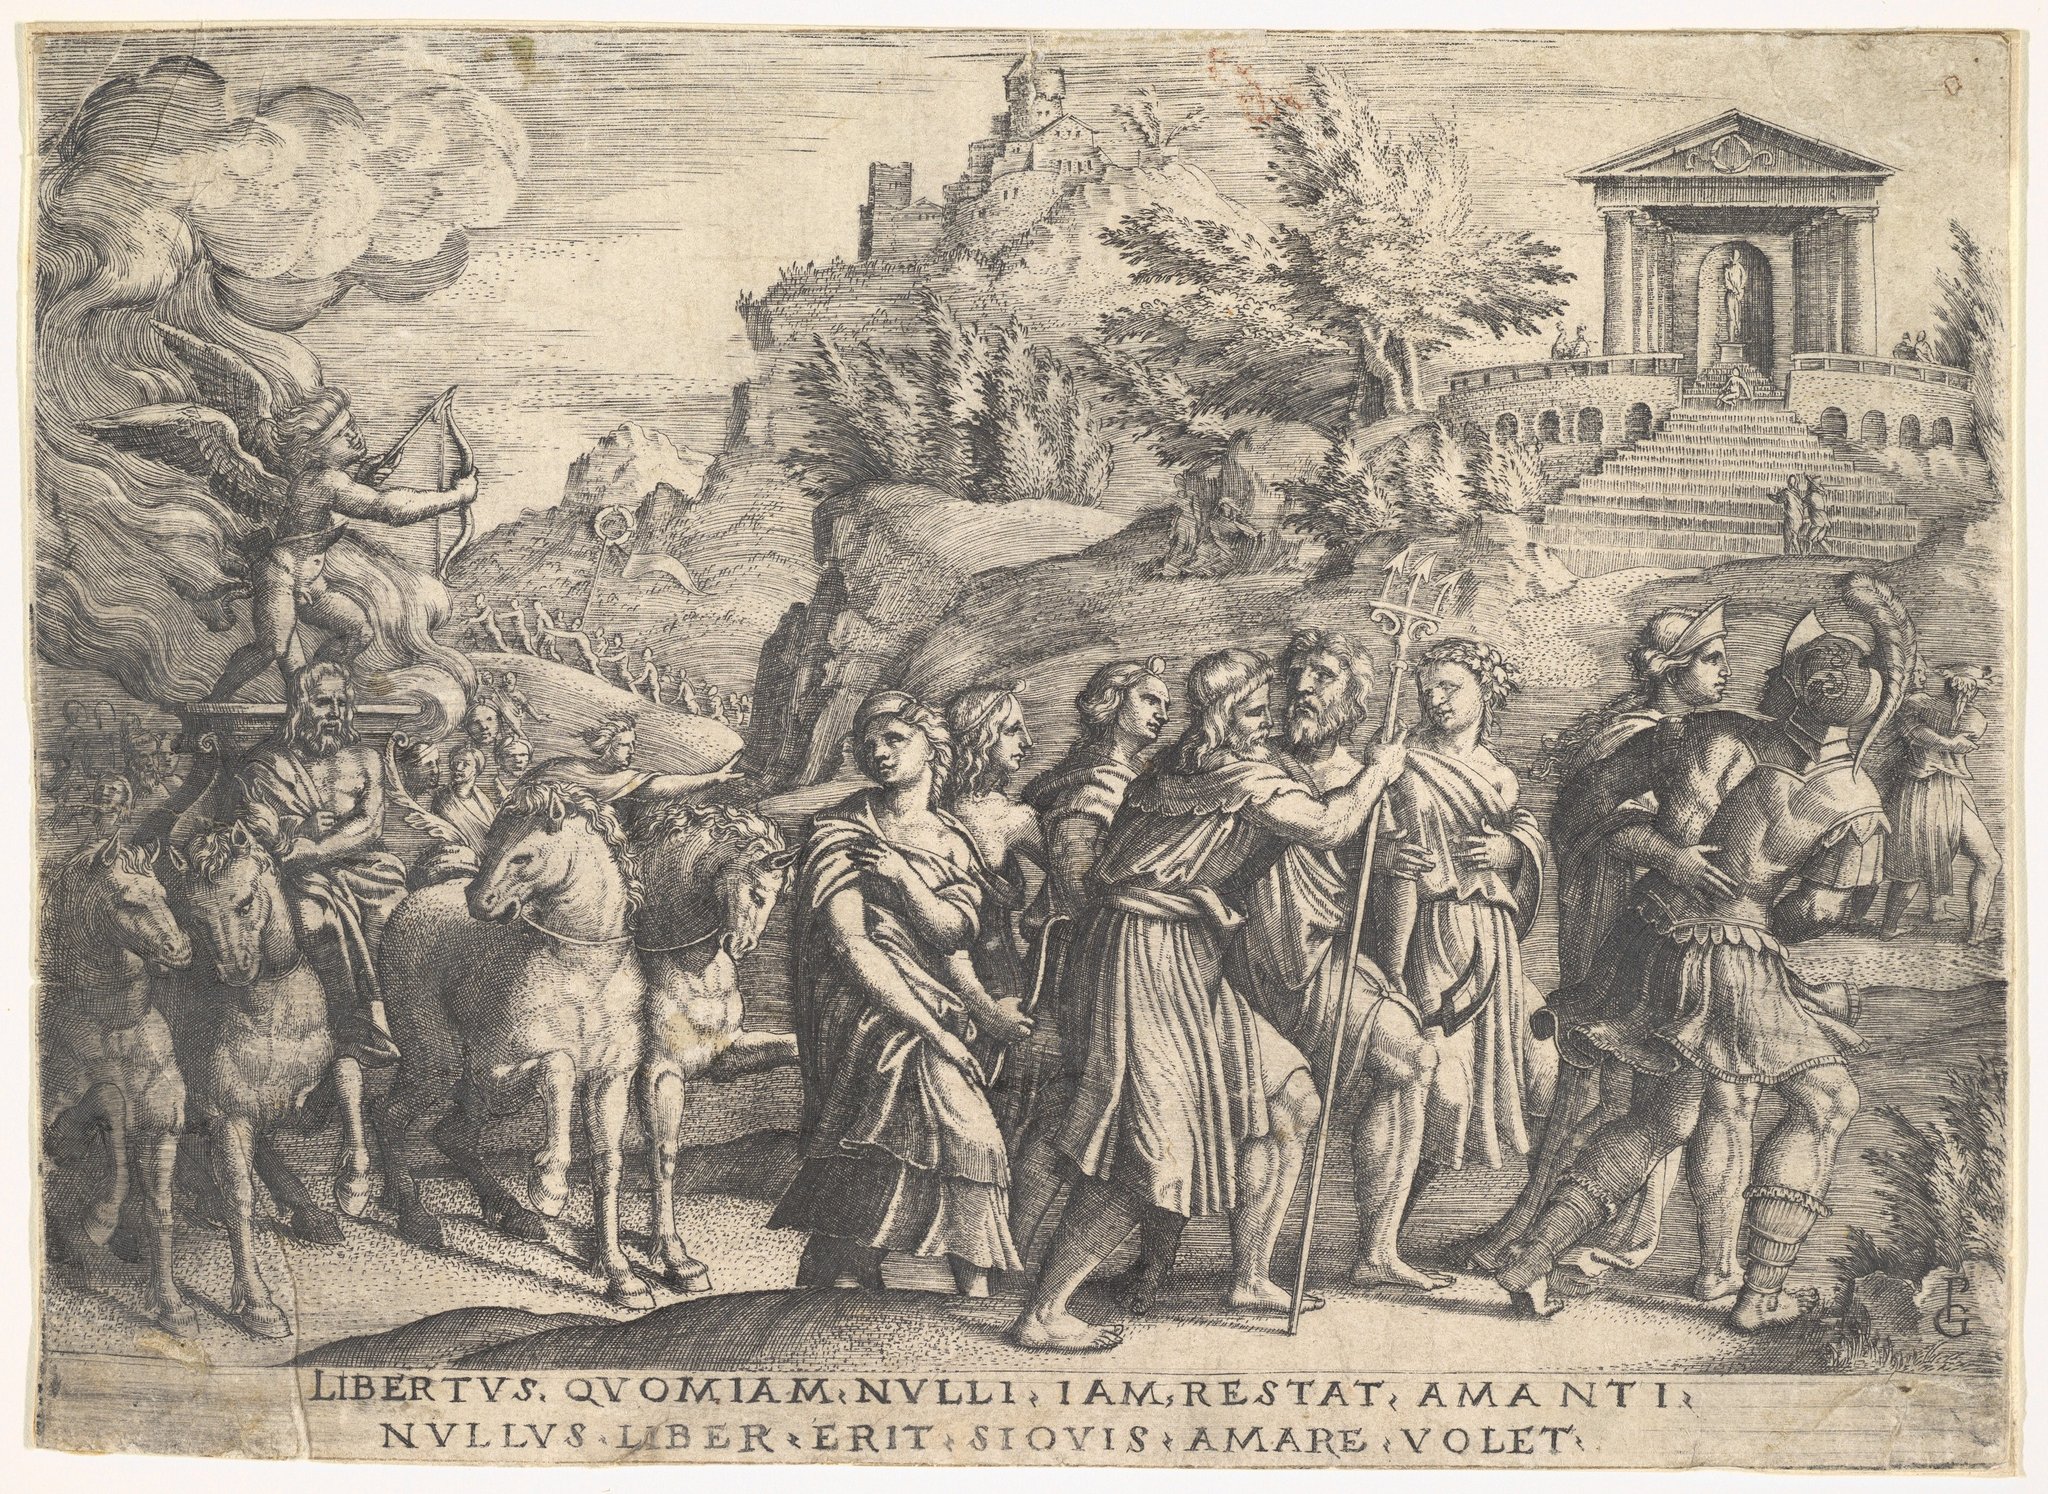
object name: print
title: Triumph of Love: four horses draw a carriage with Cupid standing upon a smoking platform, preceded by gods and goddesses on foot, a temple with gabled pediment at crest of hill beyond, from "The Triumphs of Petrarch"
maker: georg pencz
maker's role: artist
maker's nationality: german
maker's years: 1500-1550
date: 1539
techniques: engraving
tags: temples,cupid,gods,goddess,carriages